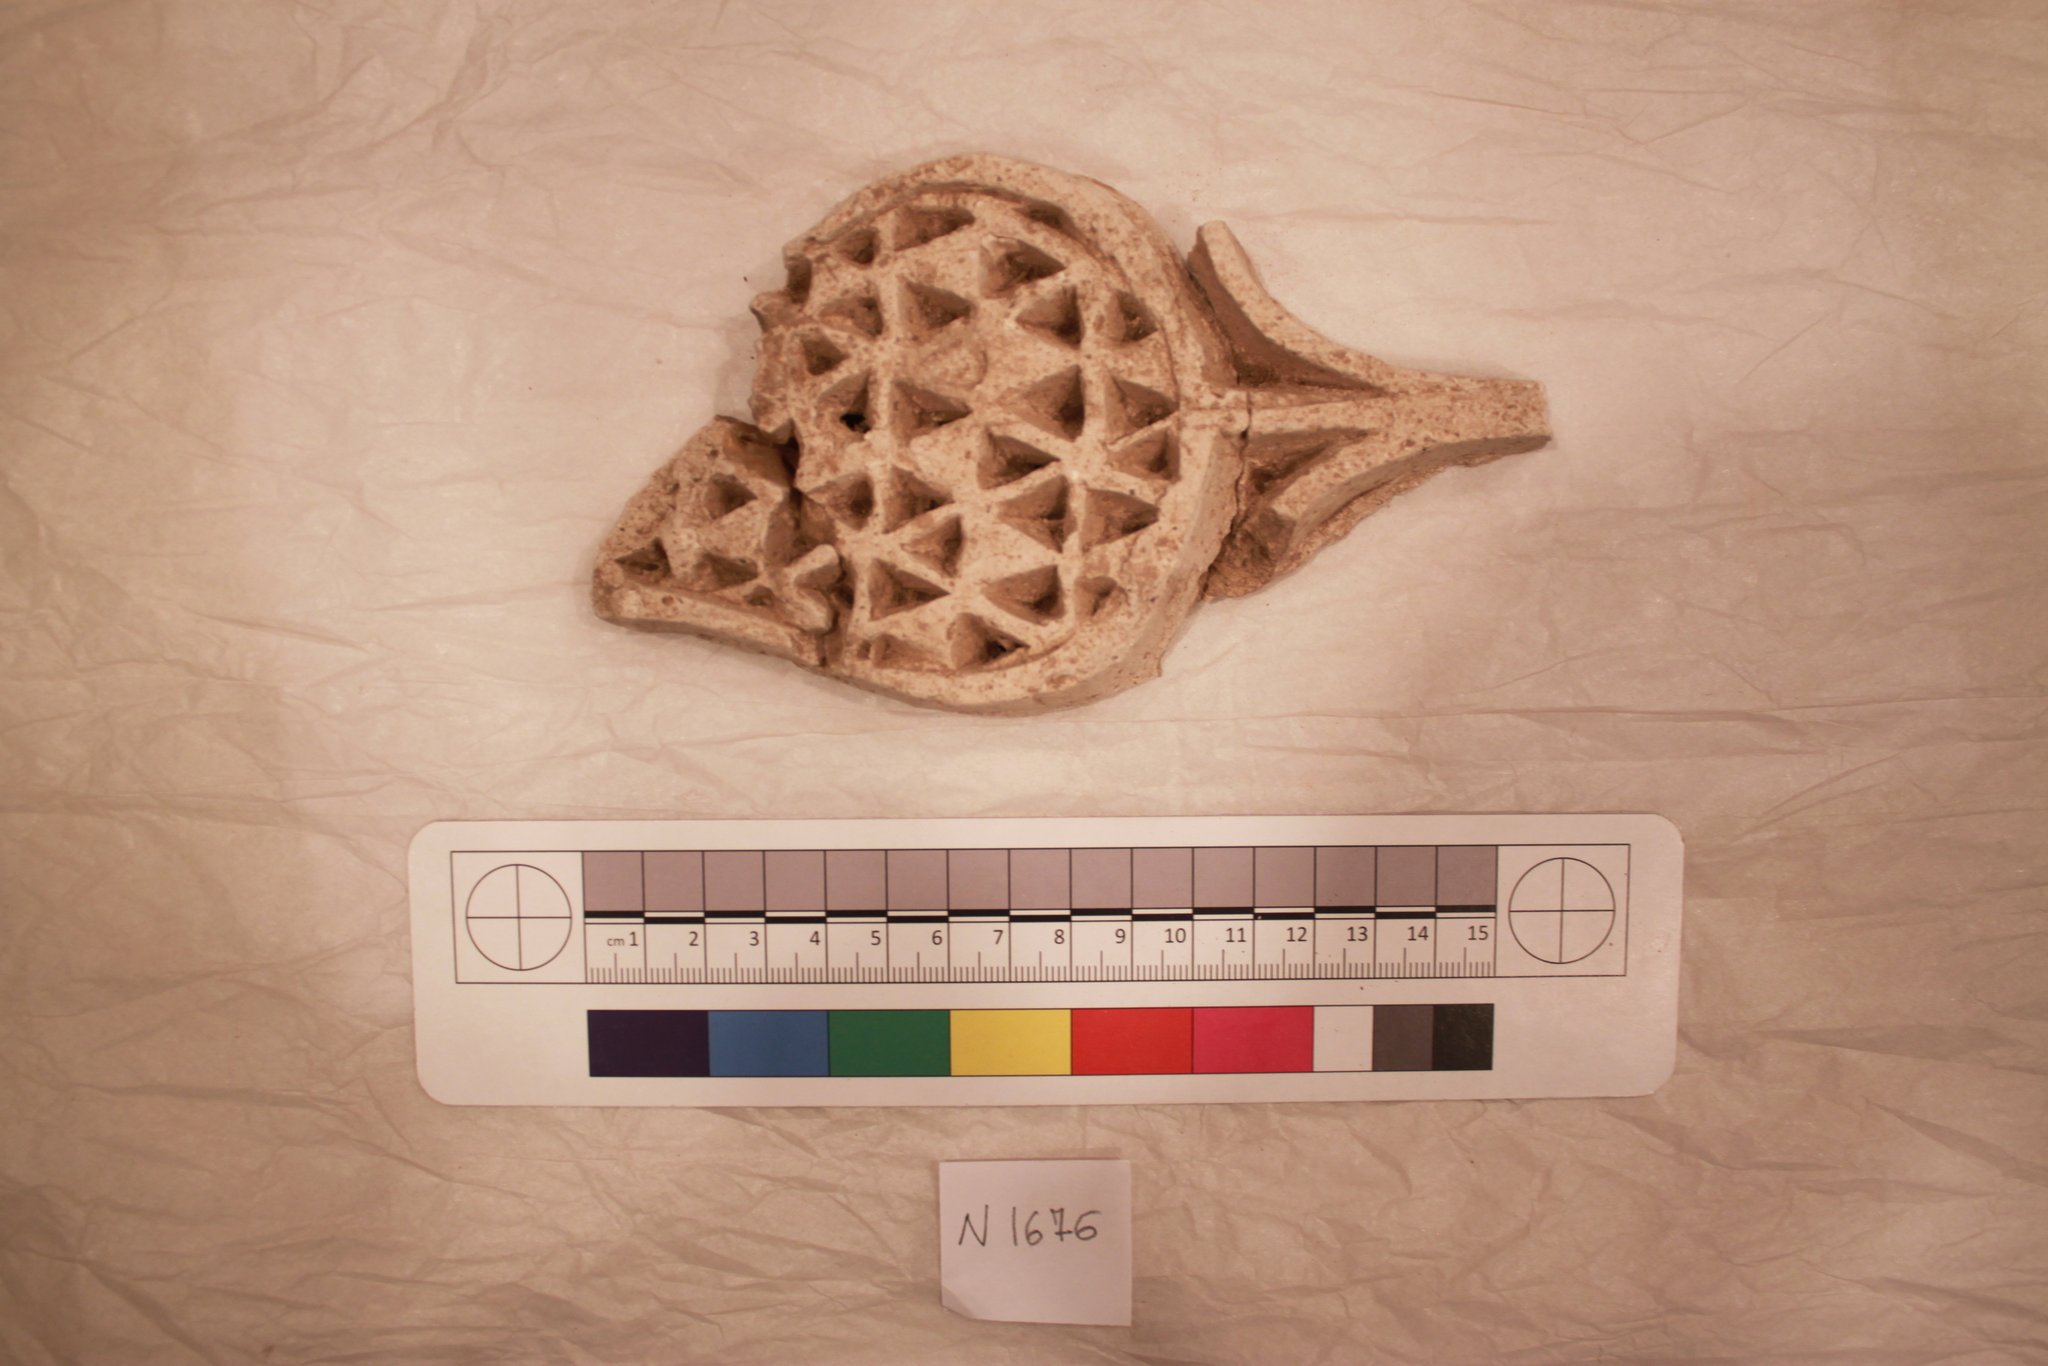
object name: fragment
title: Stucco Fragment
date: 701-1200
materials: plaster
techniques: carving, painting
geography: iran